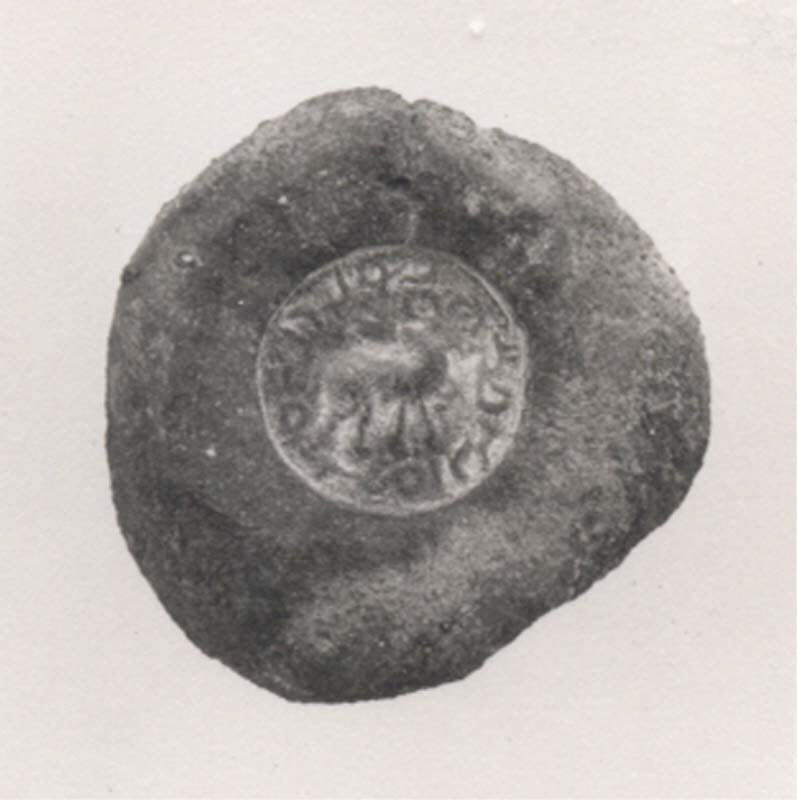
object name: sealing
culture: sasanian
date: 601-700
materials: clay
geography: iran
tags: animals